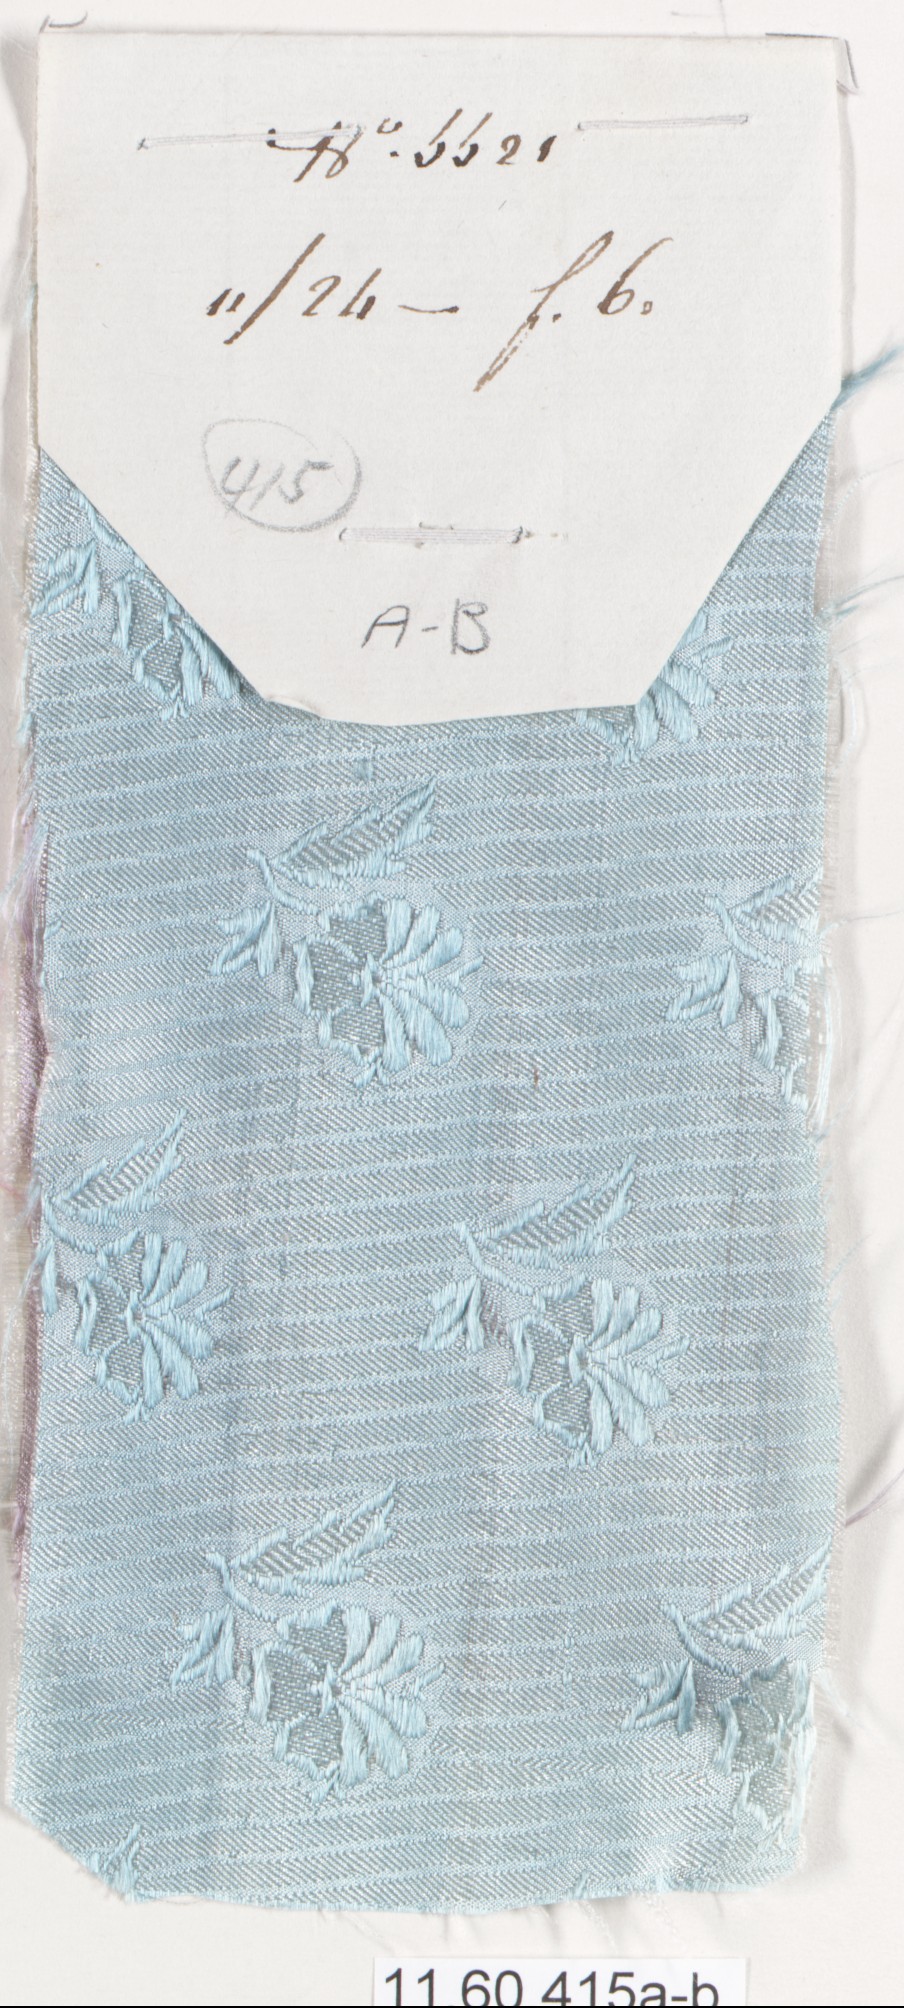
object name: fragment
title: Fragments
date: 1801-1900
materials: silk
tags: flowers,leaves